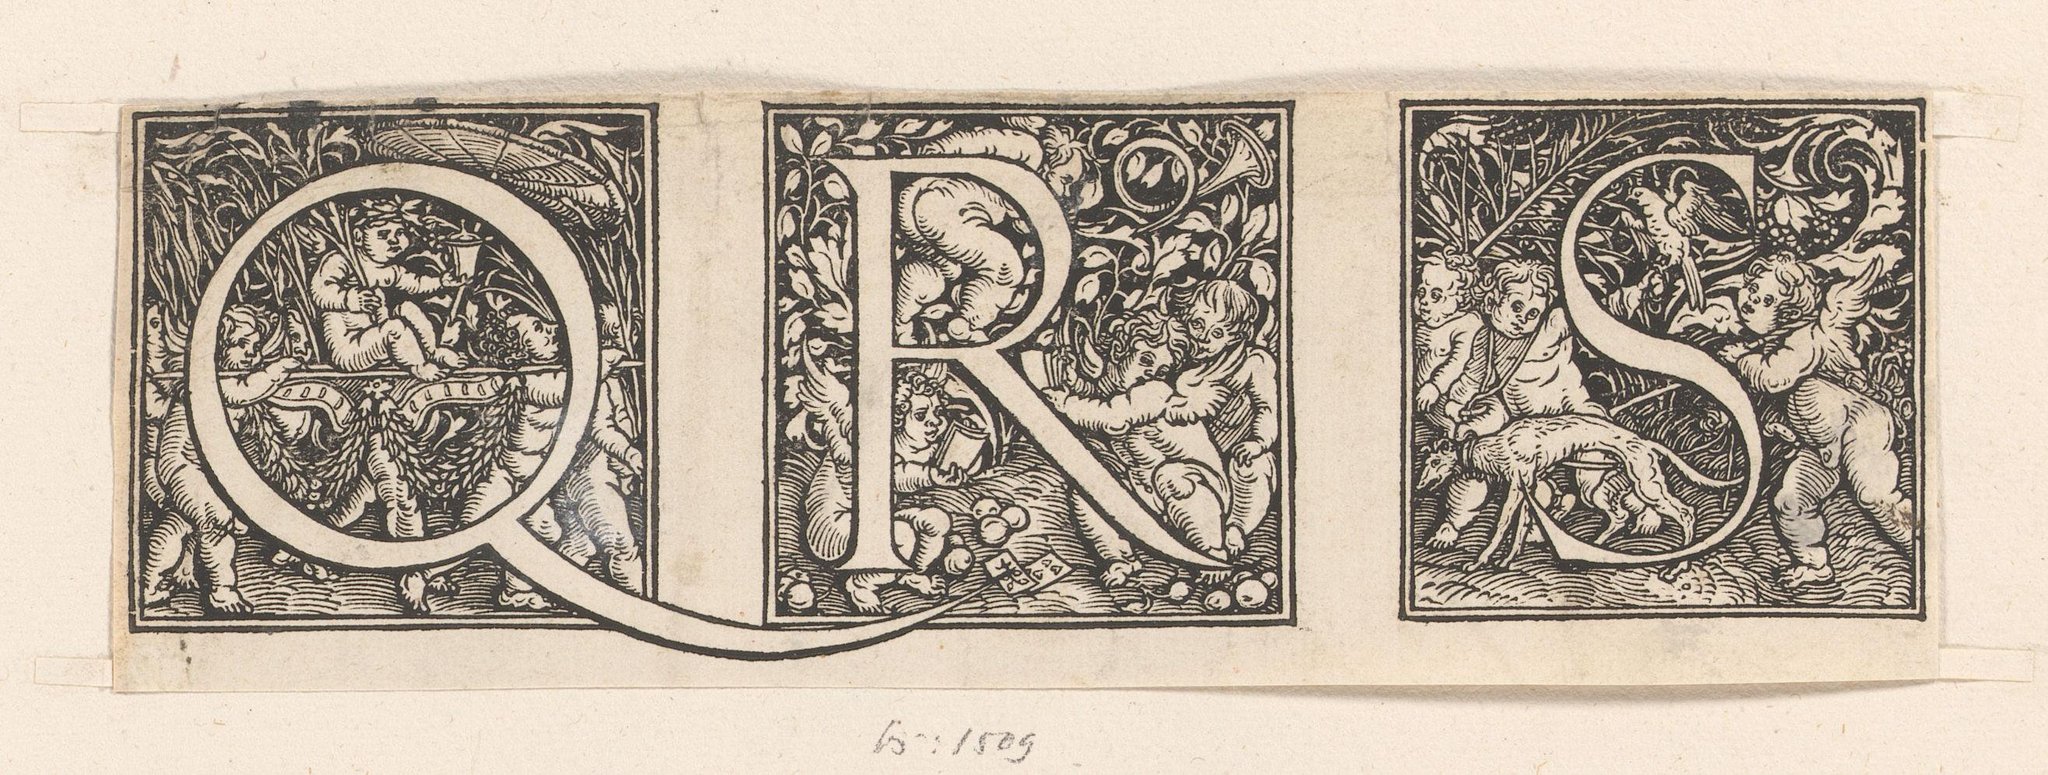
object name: album leaf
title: Initialen Q, R en S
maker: jost de negker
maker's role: print maker, printer, publisher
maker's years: 1485-1544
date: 1521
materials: paper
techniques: woodcut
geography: augsburg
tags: initial, cupids: 'amores', 'amoretti', 'putti'